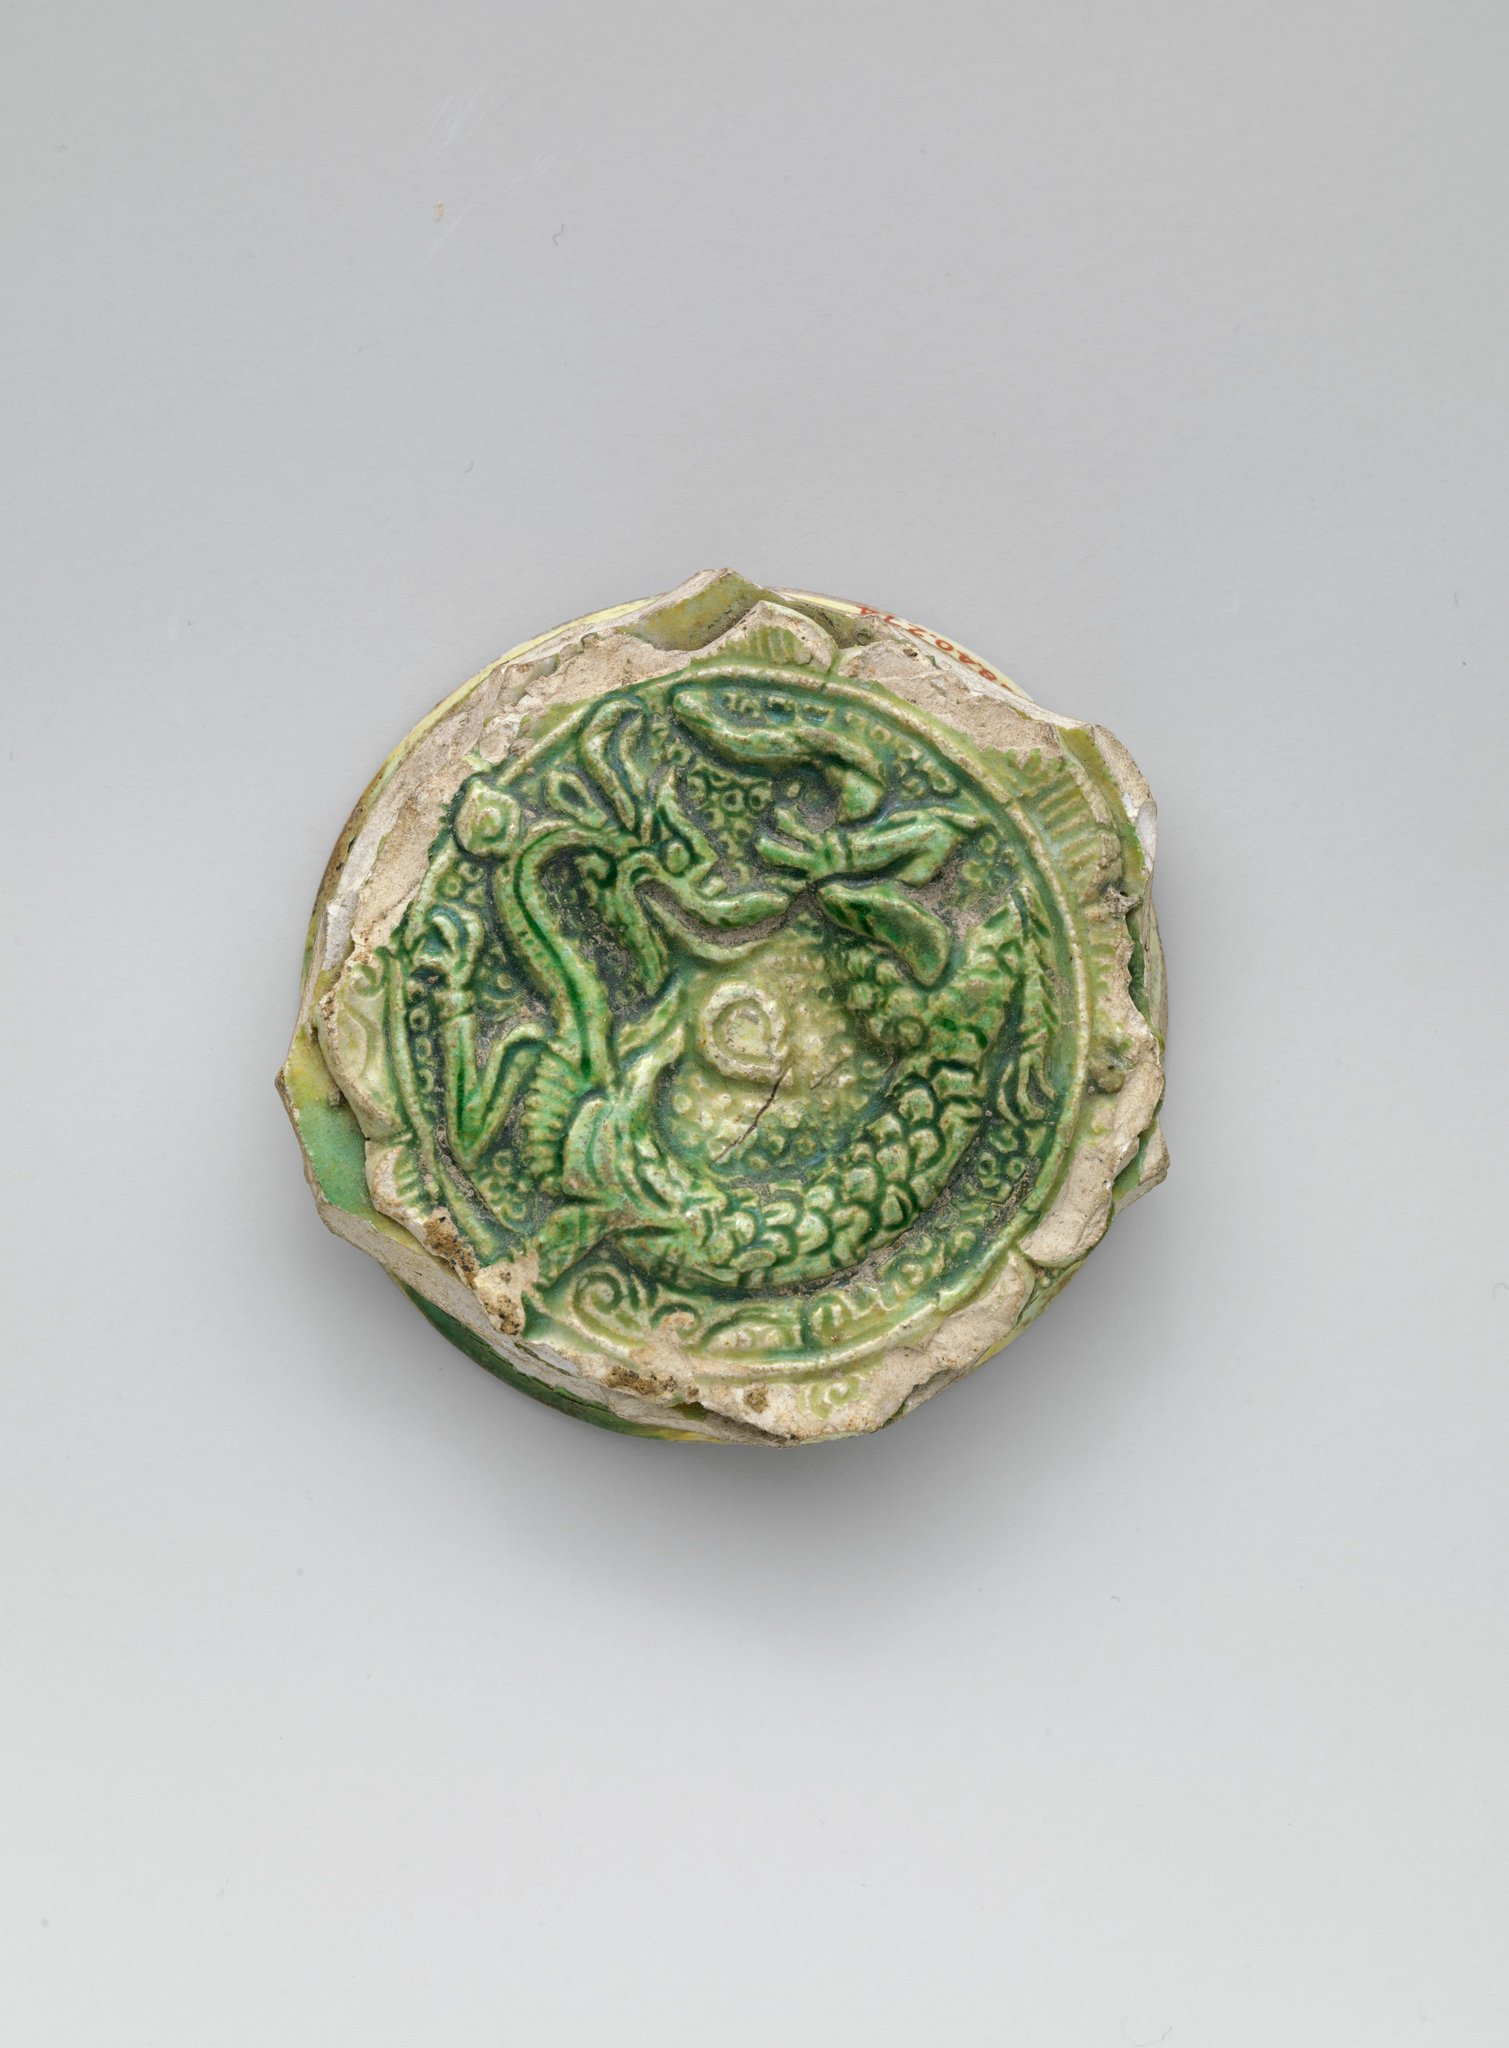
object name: fragment of a bowl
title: Fragment of an Imported Chinese Bowl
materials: earthenware, glaze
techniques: relief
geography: china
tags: dragons